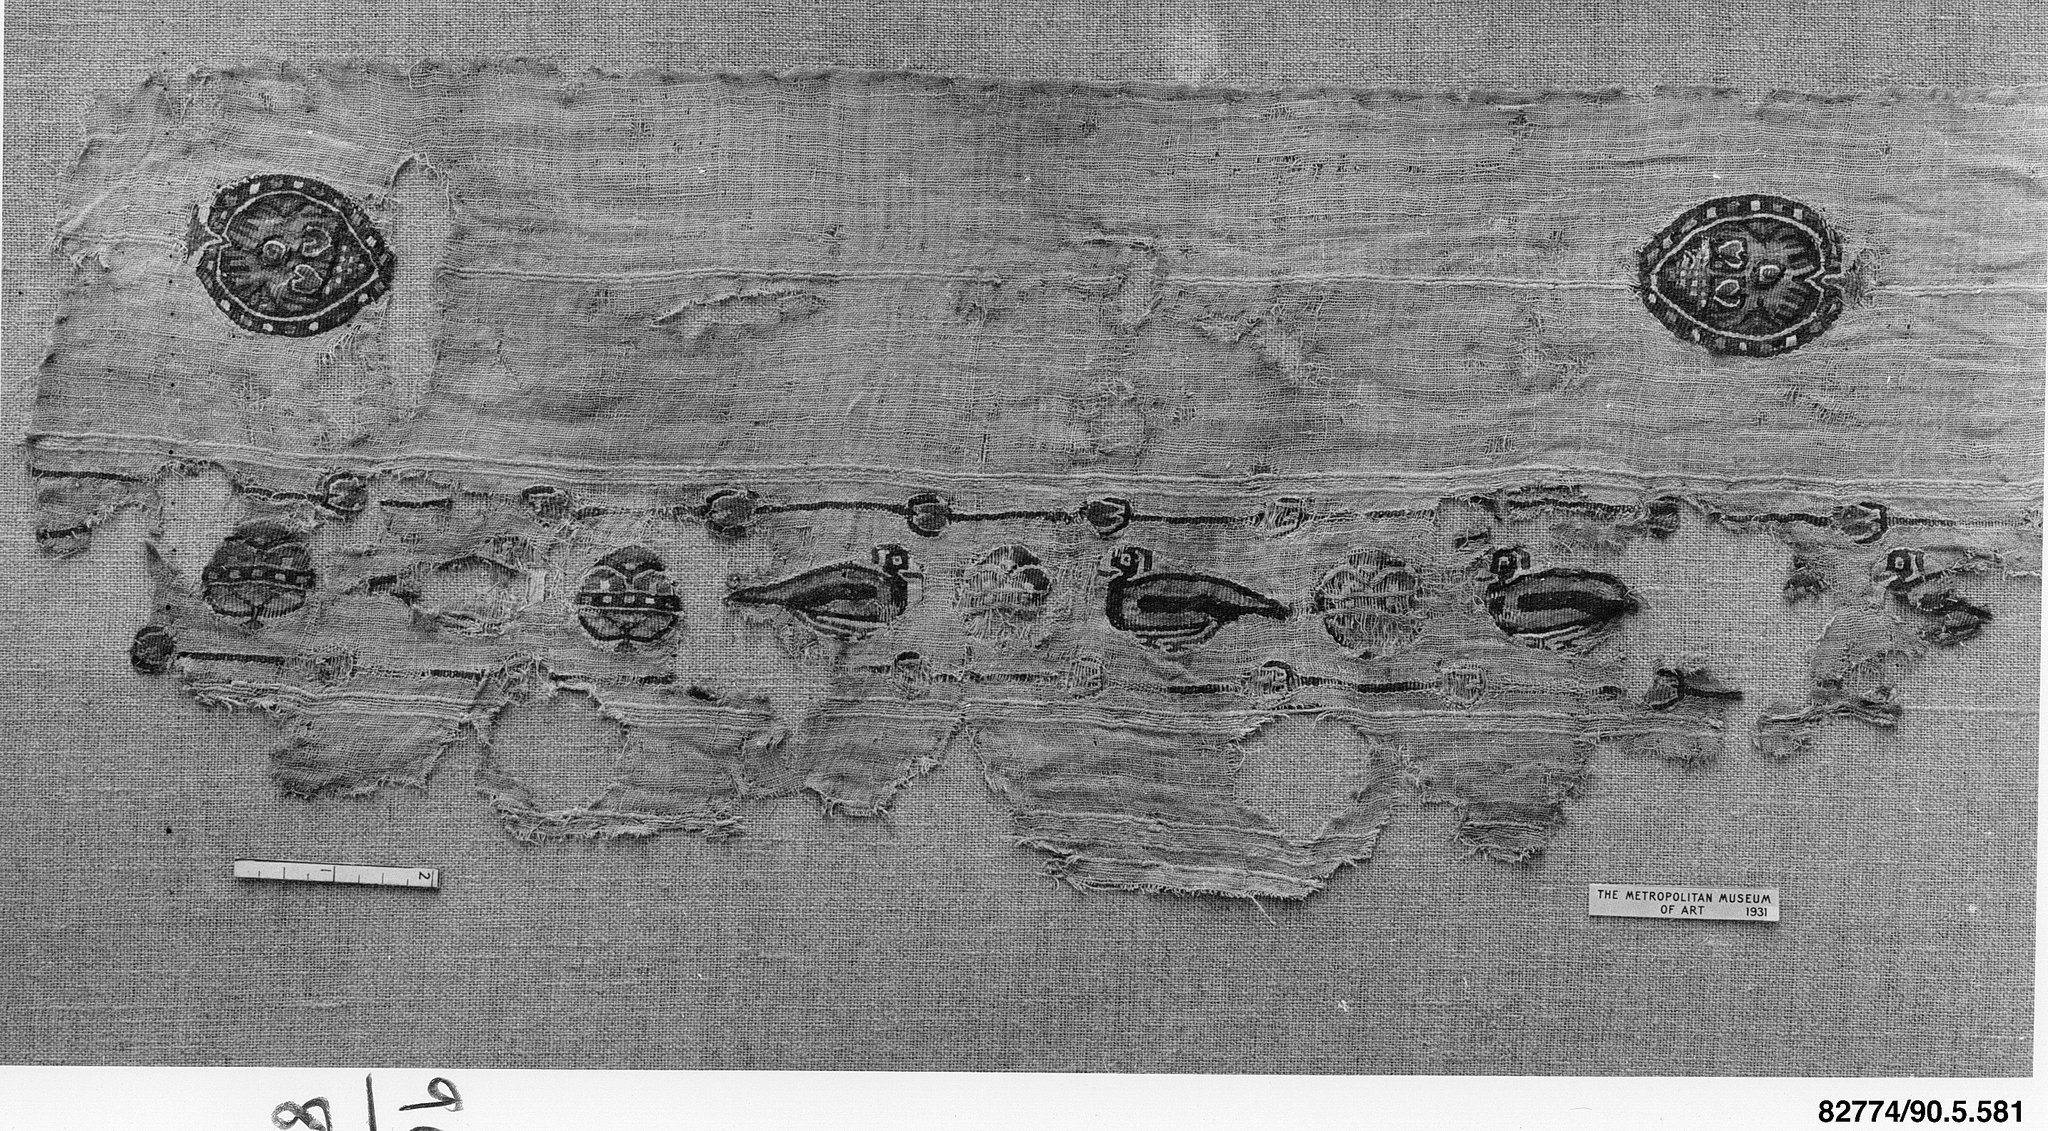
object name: textile fragment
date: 401-500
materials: linen, wool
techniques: weave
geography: egypt